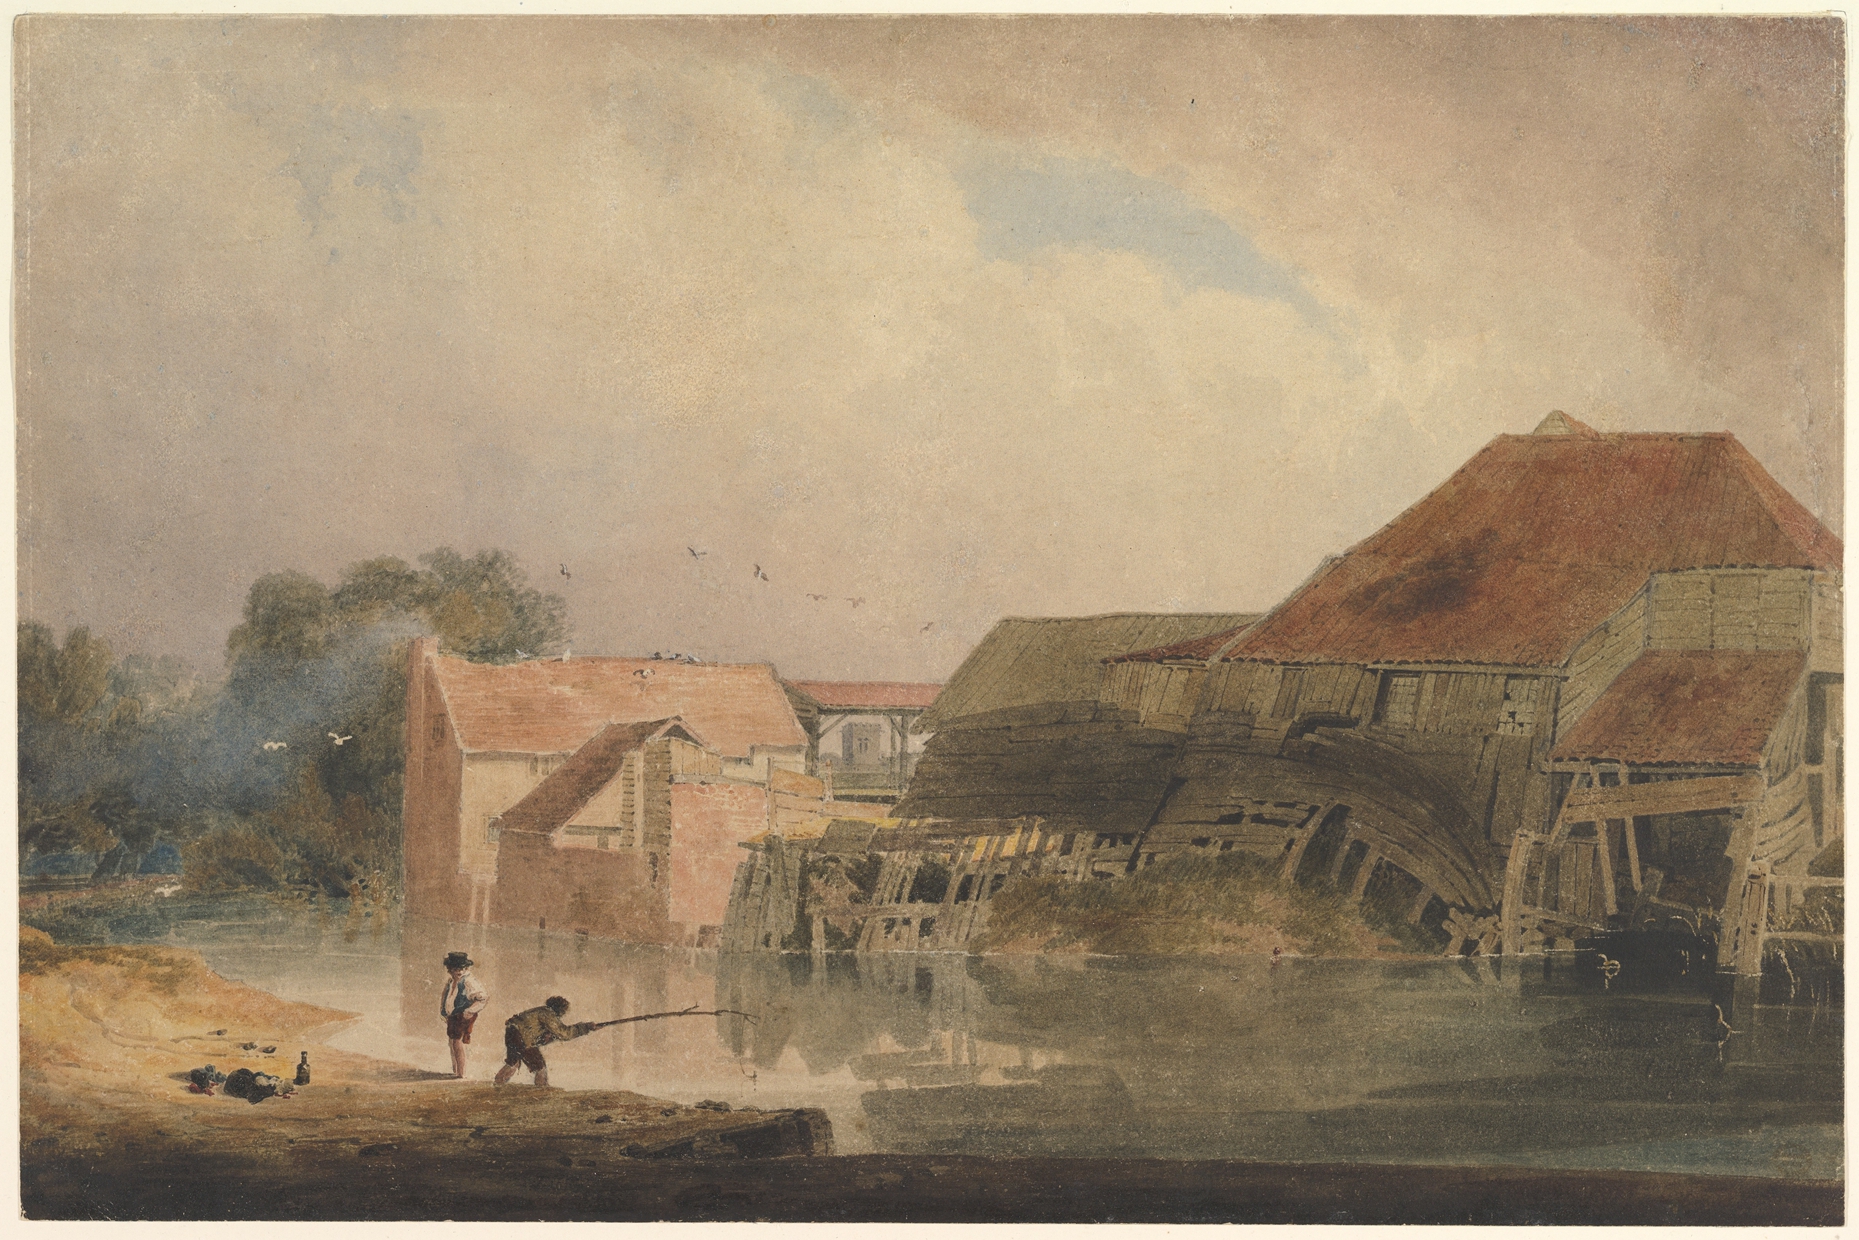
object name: drawing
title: Riverside Scene (Old Mill)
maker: peter de wint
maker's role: artist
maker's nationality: british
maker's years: 1784-1849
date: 1805-1810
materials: watercolor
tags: human figures,ruins,fishing,rivers,trees